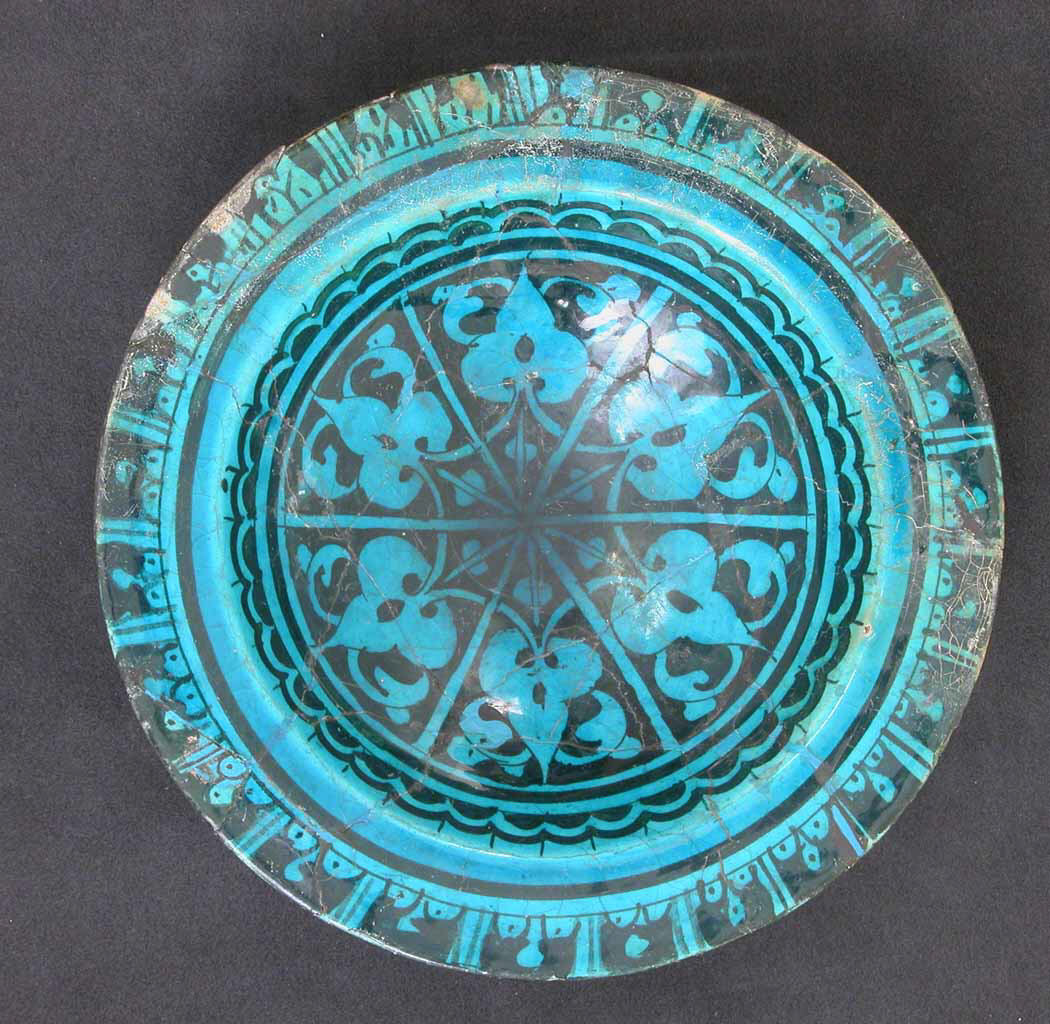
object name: bowl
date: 1101-1200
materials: stonepaste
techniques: painting, underglaze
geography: syria